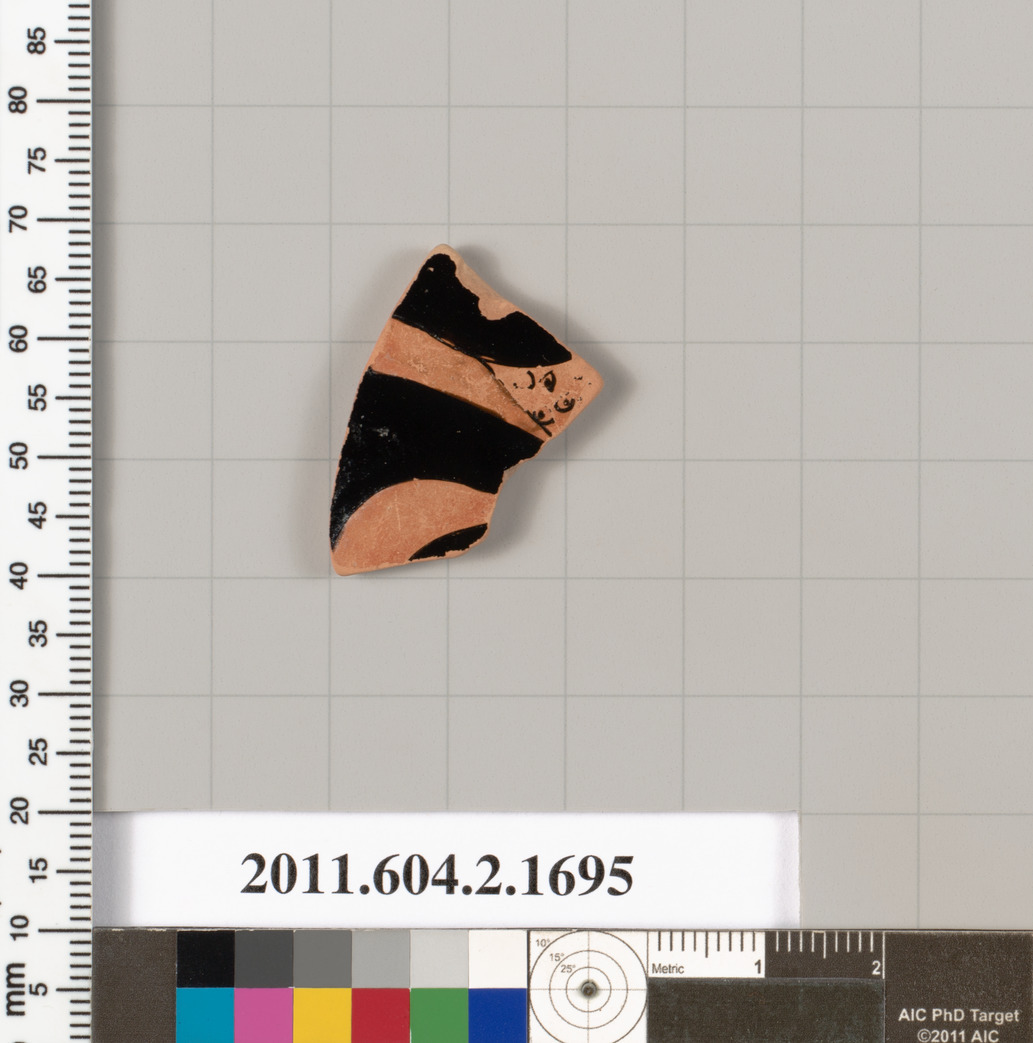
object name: skyphos fragment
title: Terracotta rim fragment of a skyphos (deep drinking cup)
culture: greek, attic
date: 490-480 BCE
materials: terracotta